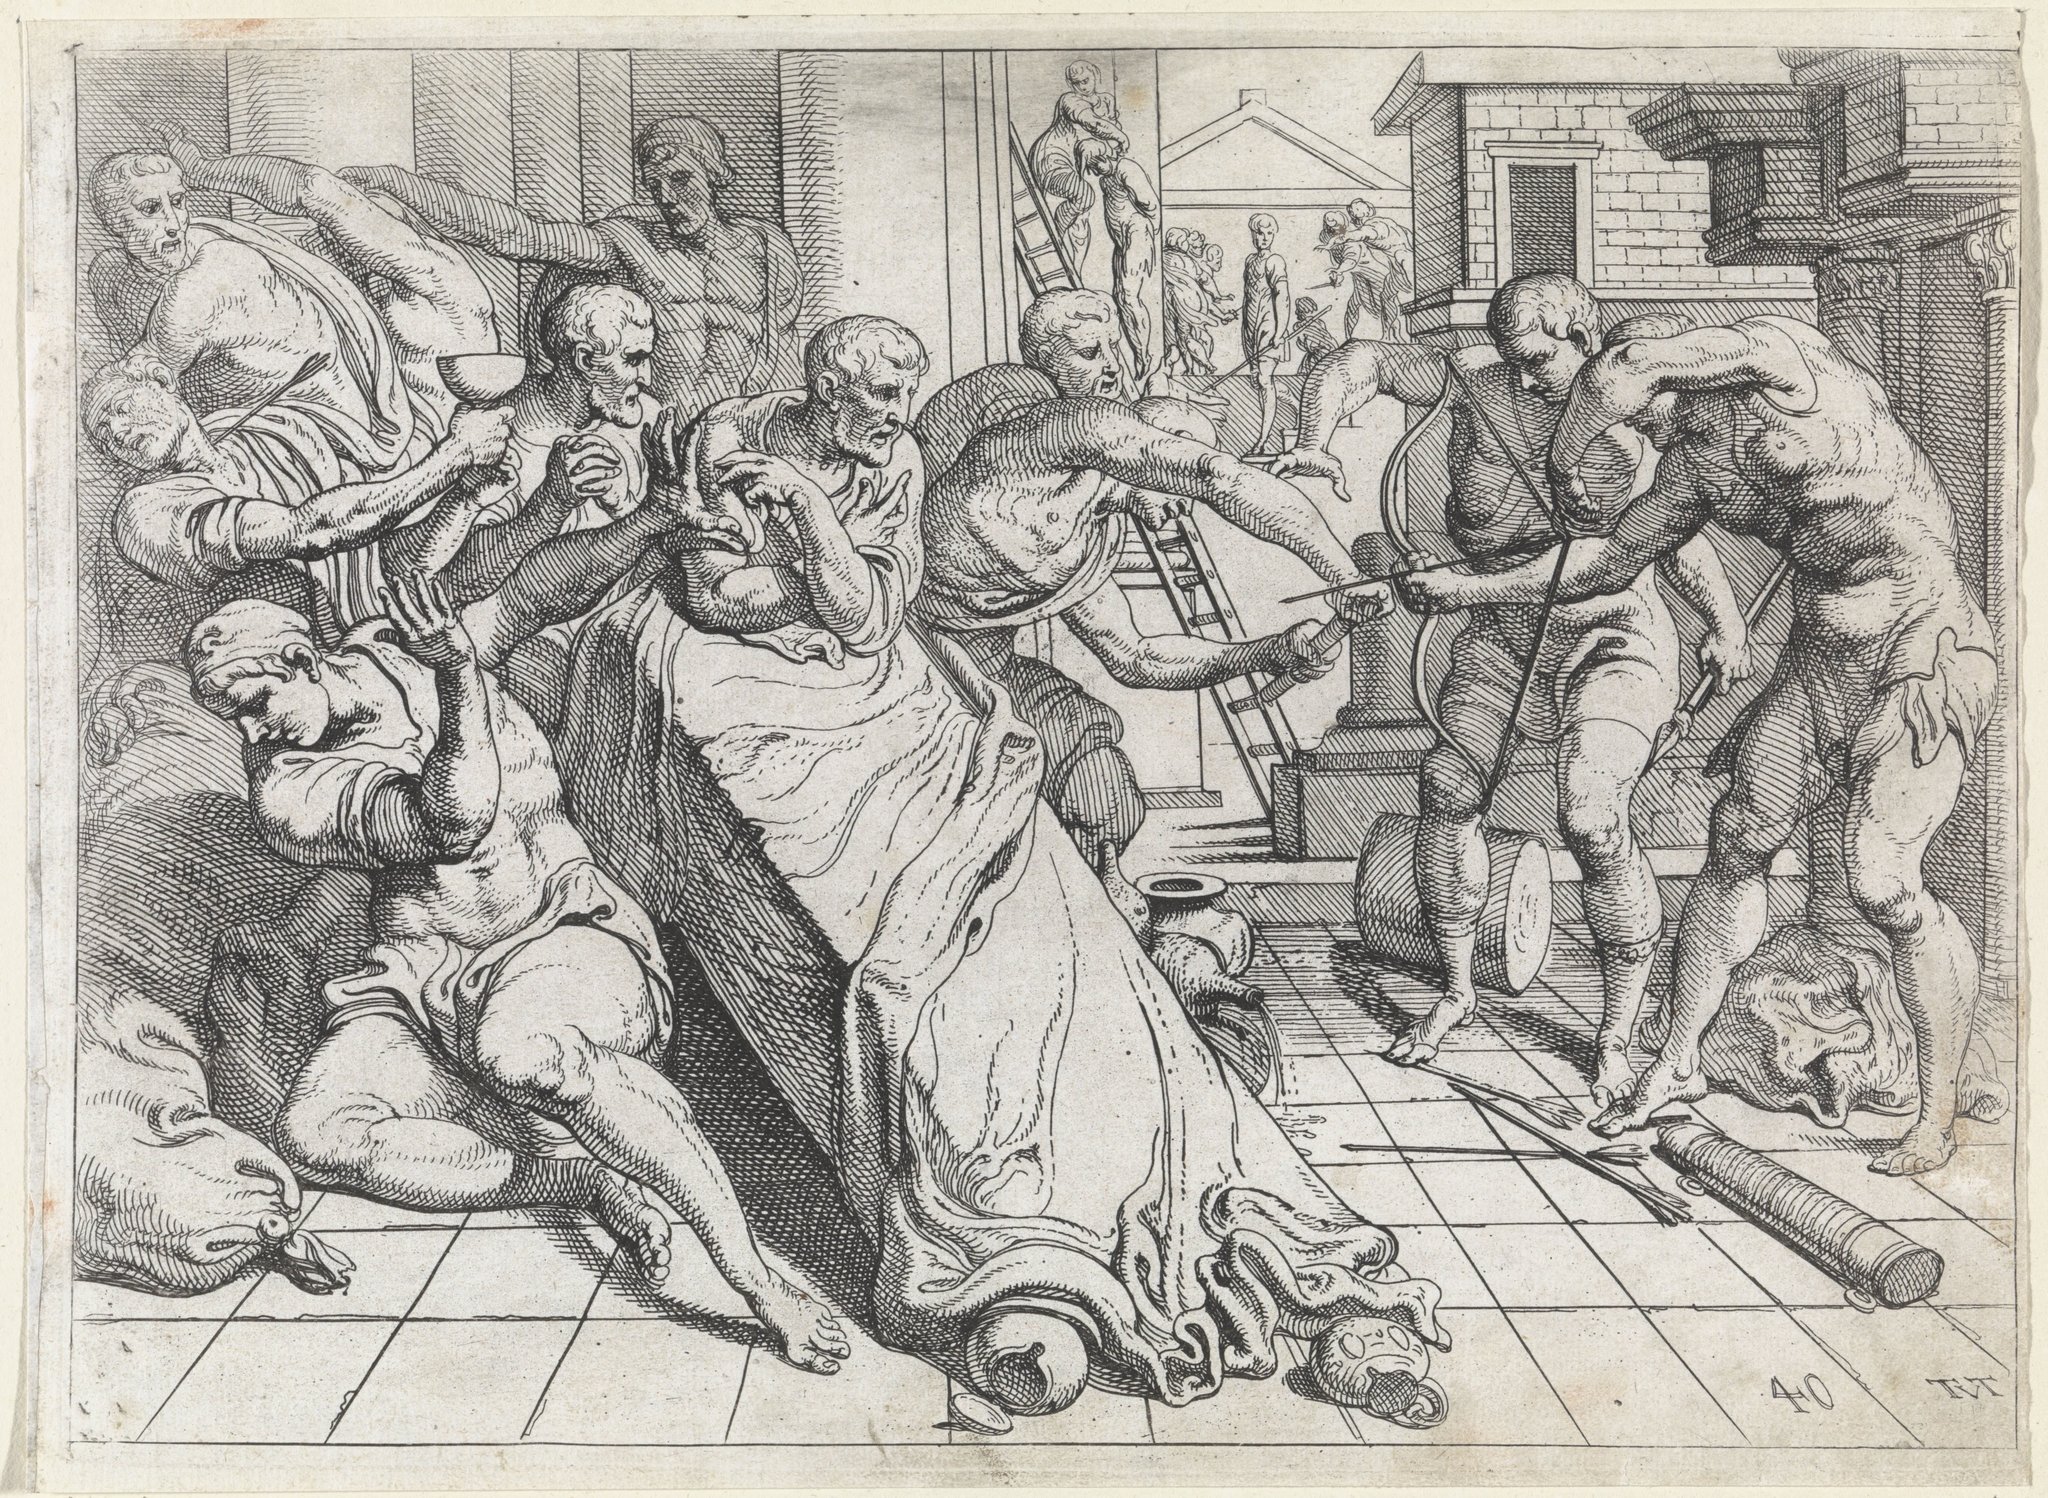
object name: print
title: De werken van Odysseus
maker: theodoor van thulden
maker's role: draughtsman, painter, print maker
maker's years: 1606-1669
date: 1632-1633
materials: paper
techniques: engraving, etching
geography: paris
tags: ulysses, assisted by telemachus, kills the suitors (homer, odyssey xxii)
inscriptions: collector's mark: Lugt 2228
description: Odysseus doodt met zijn pijl en boog een van de vrijers van zijn vrouw Penelope. De andere vrijers rond de omgevallen tafel zoeken dekking.